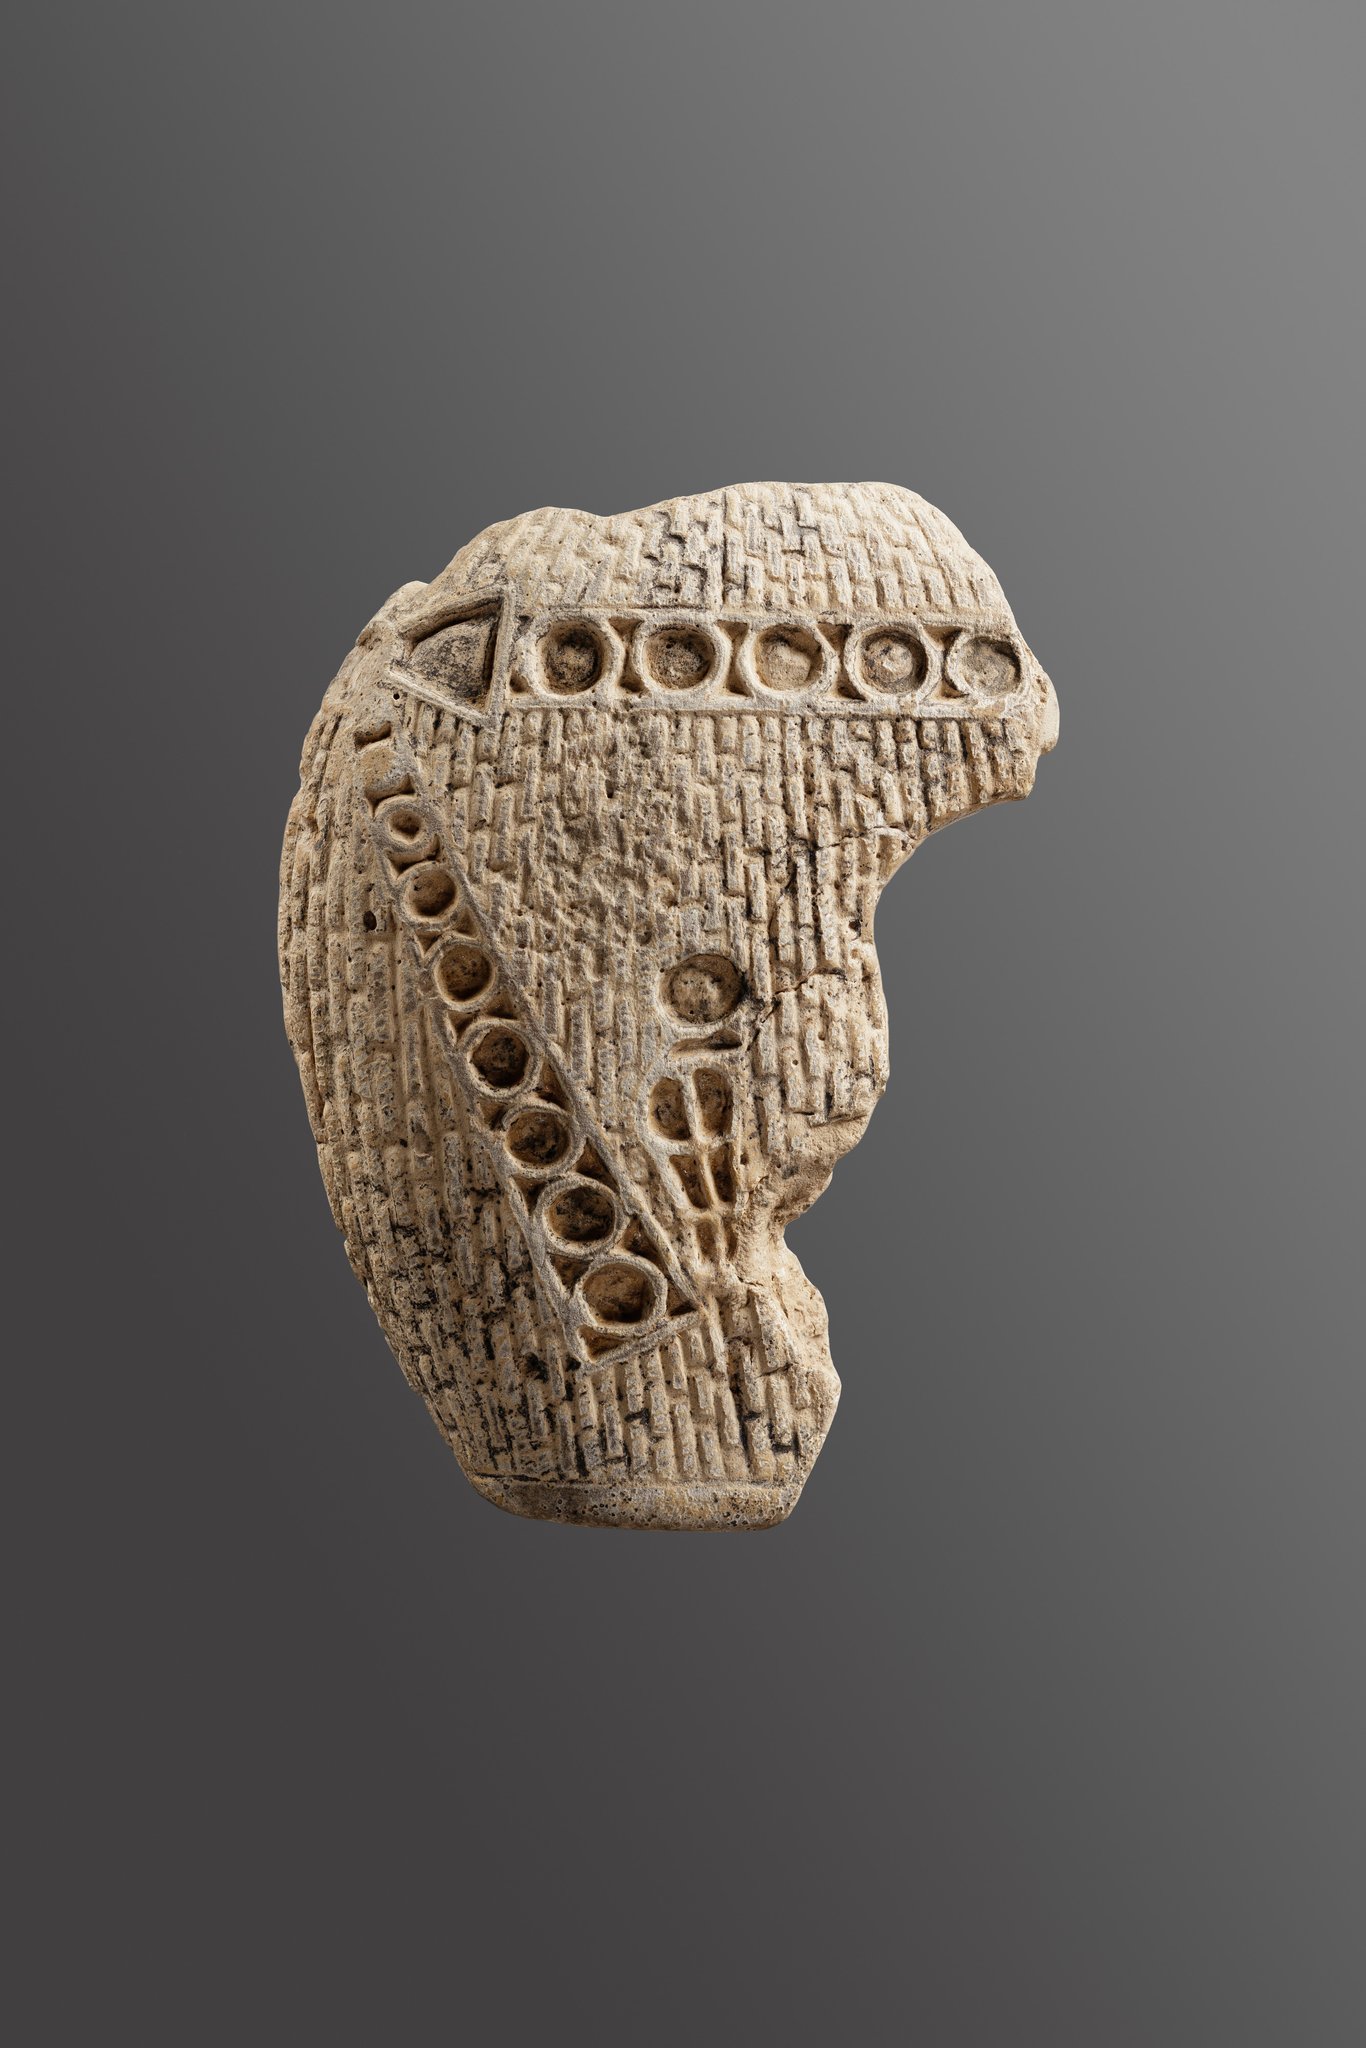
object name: statue wig fragment, inlay missing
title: Statue wig fragment, inlays missing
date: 1550-1070 BCE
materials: faience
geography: egypt